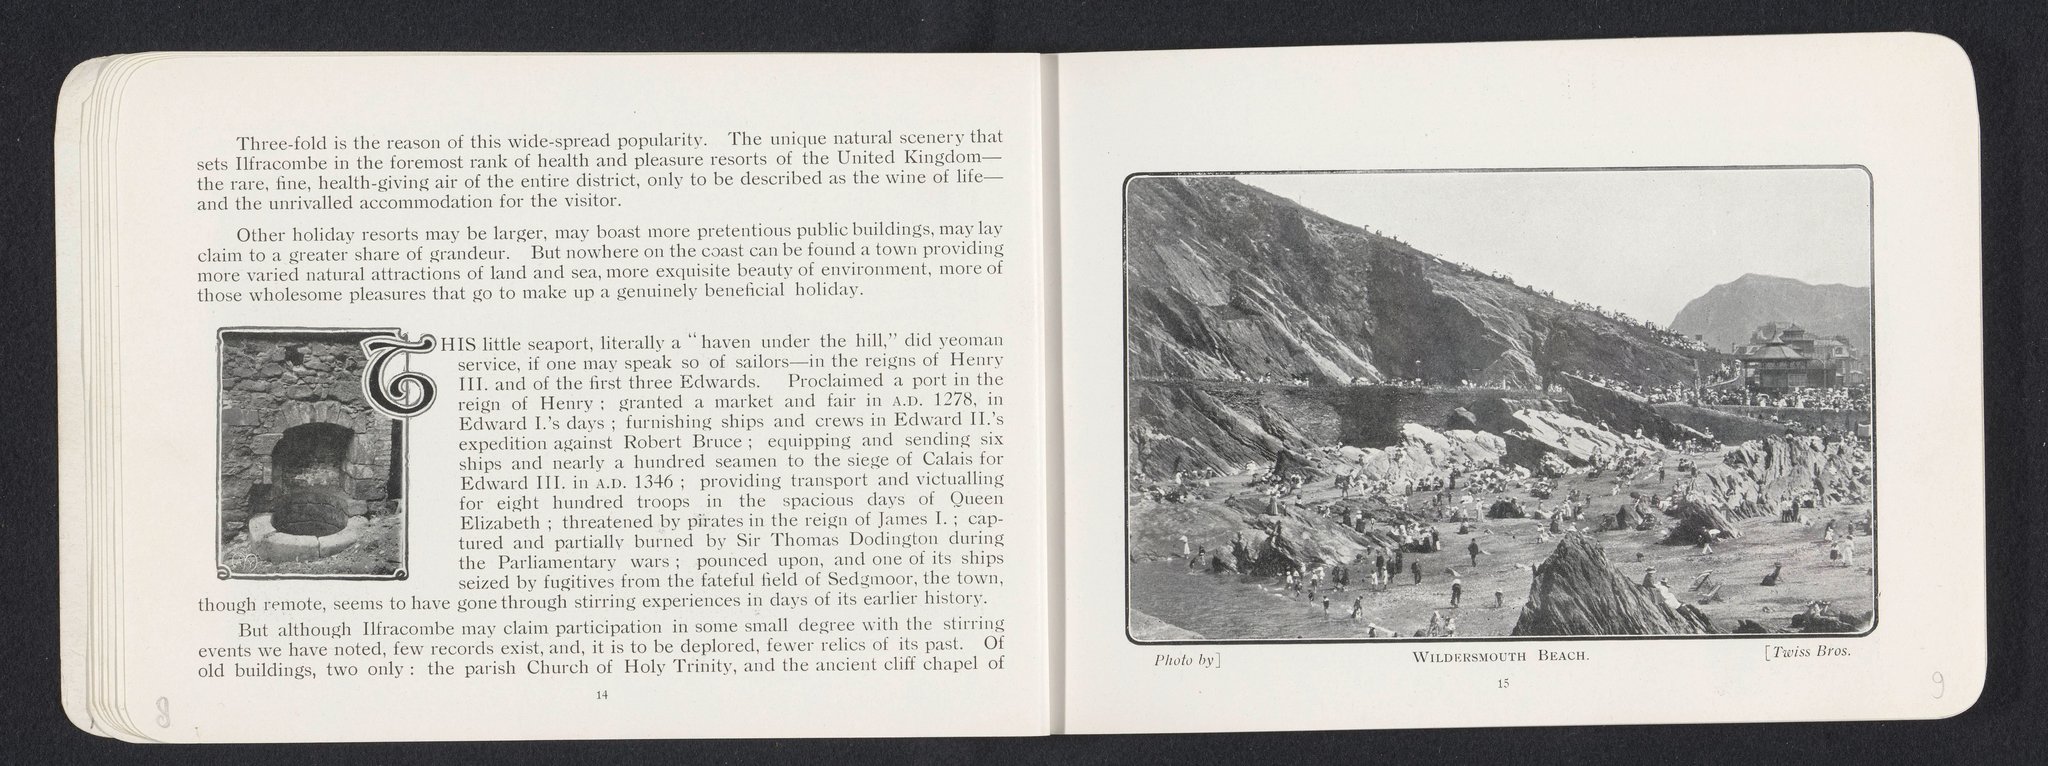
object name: photomechanical print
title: Wildersmouth Beach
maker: Anonymous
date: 1900-1920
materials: paper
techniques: autotype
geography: ilfracombe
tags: beach (as place of recreation), rocky coast